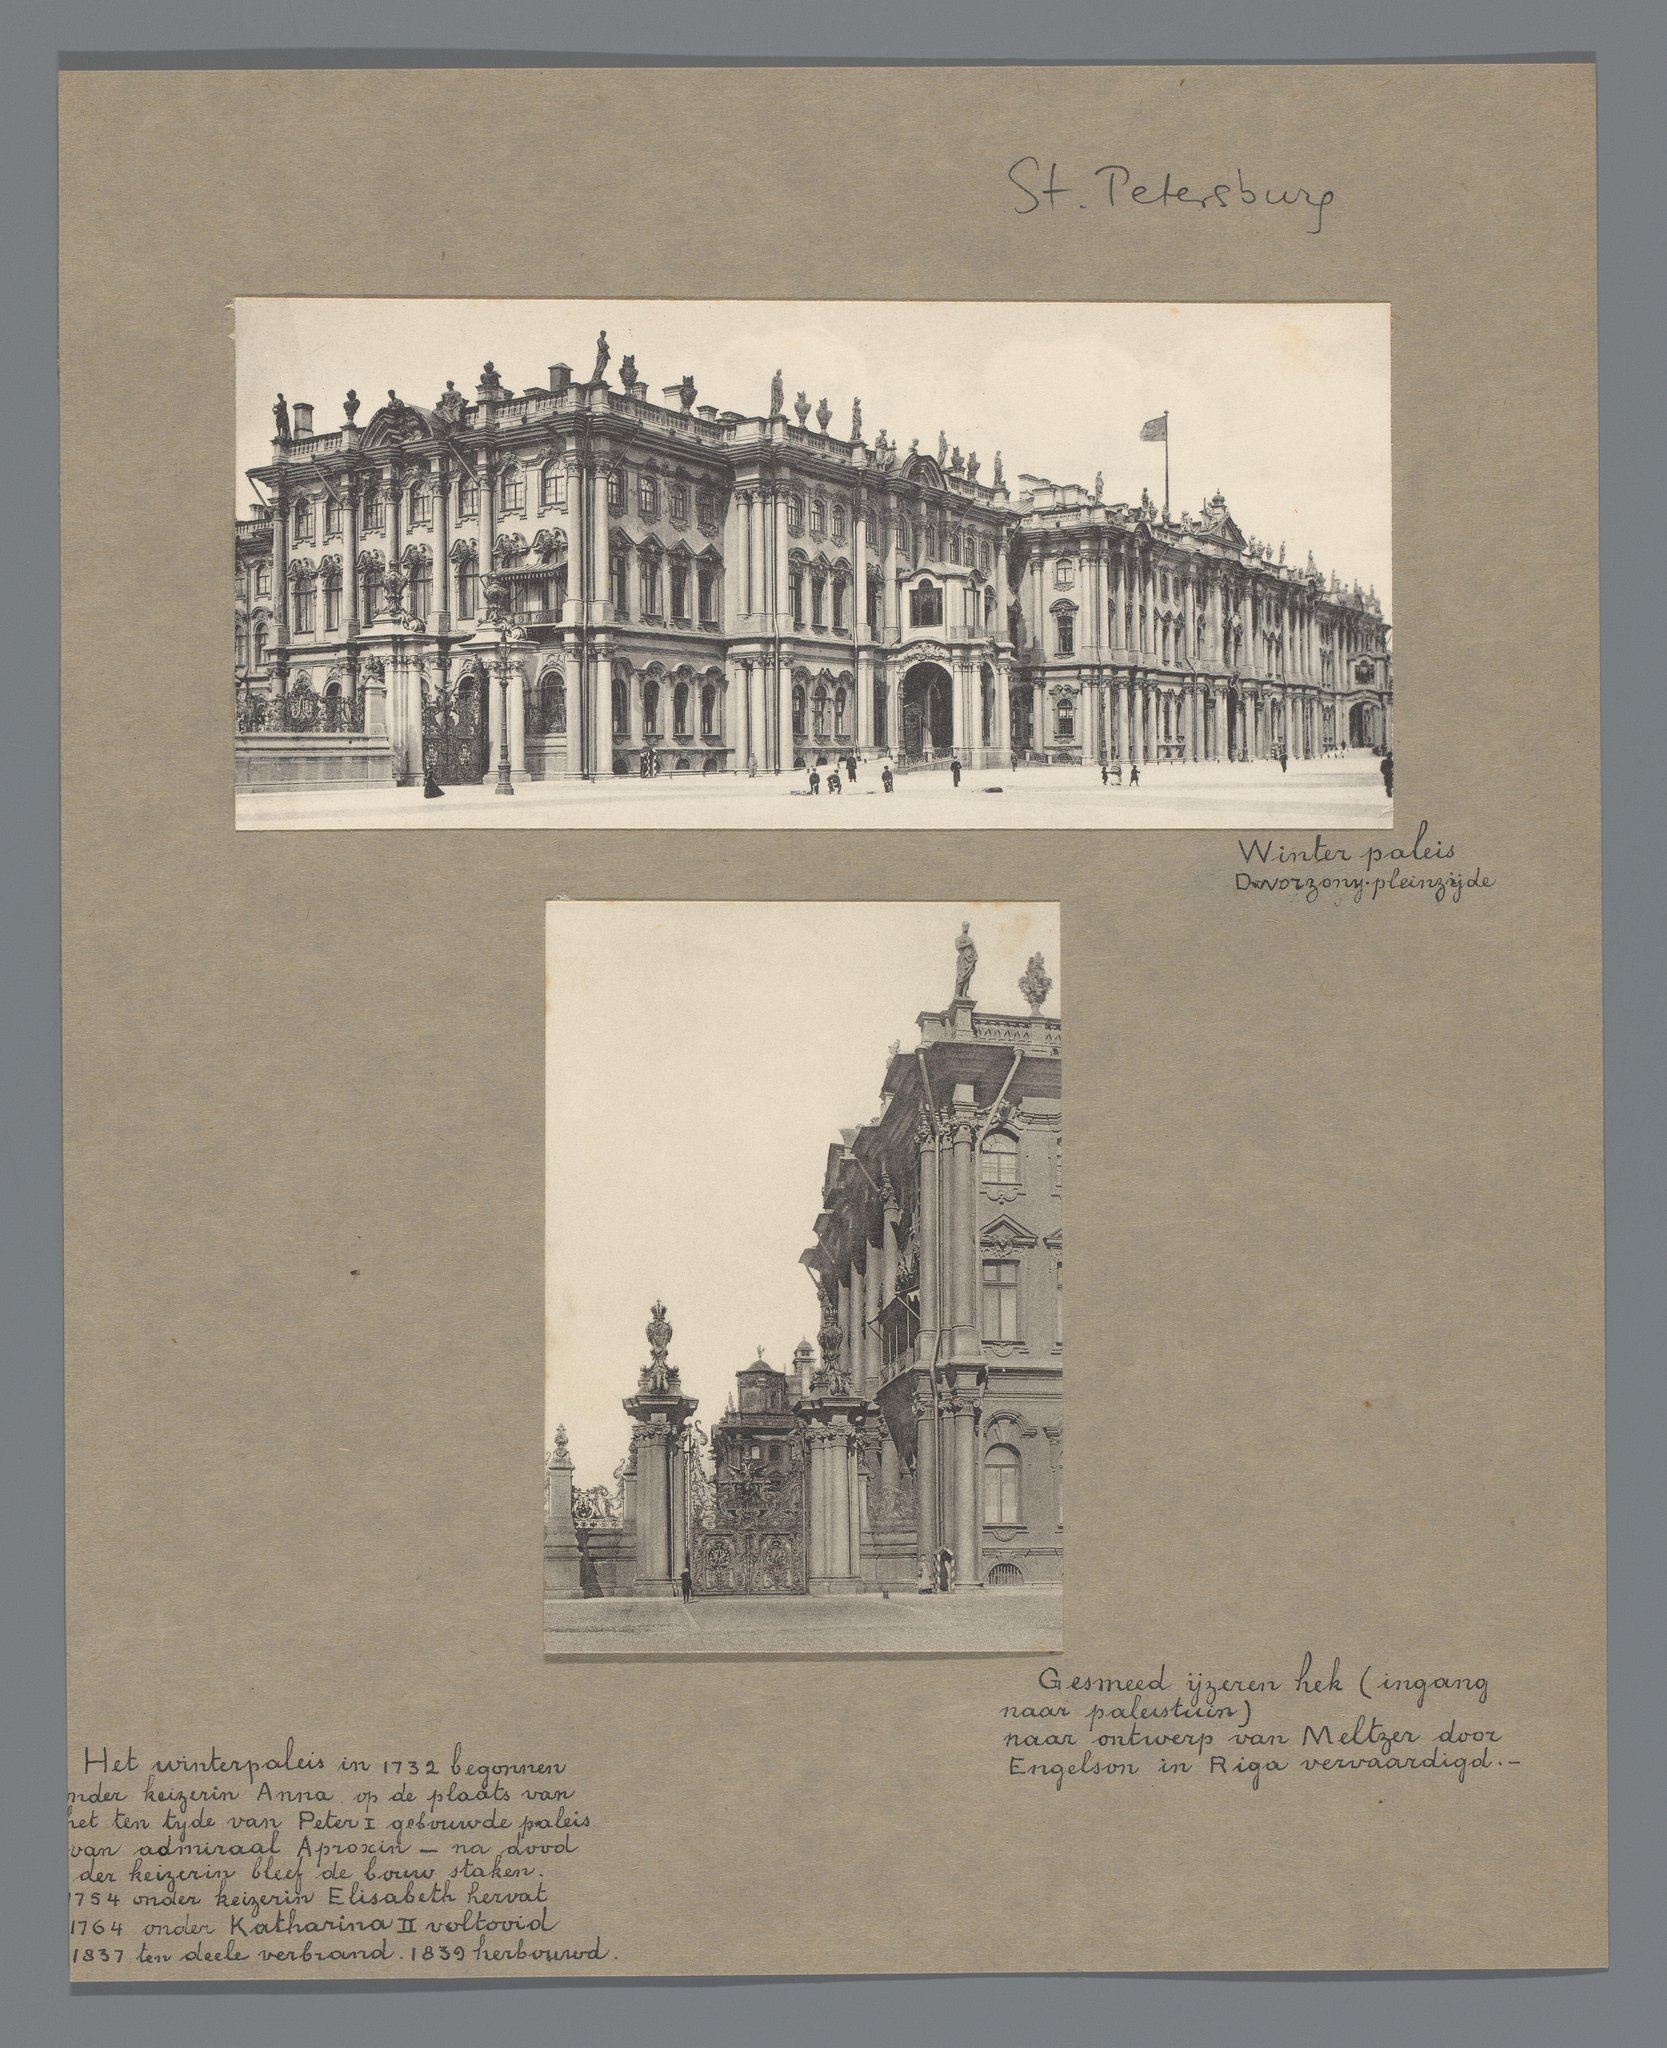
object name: photograph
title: St. Petersburg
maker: Anonymous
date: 1860-1925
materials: photographic support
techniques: photograph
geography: russia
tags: sint-petersburg